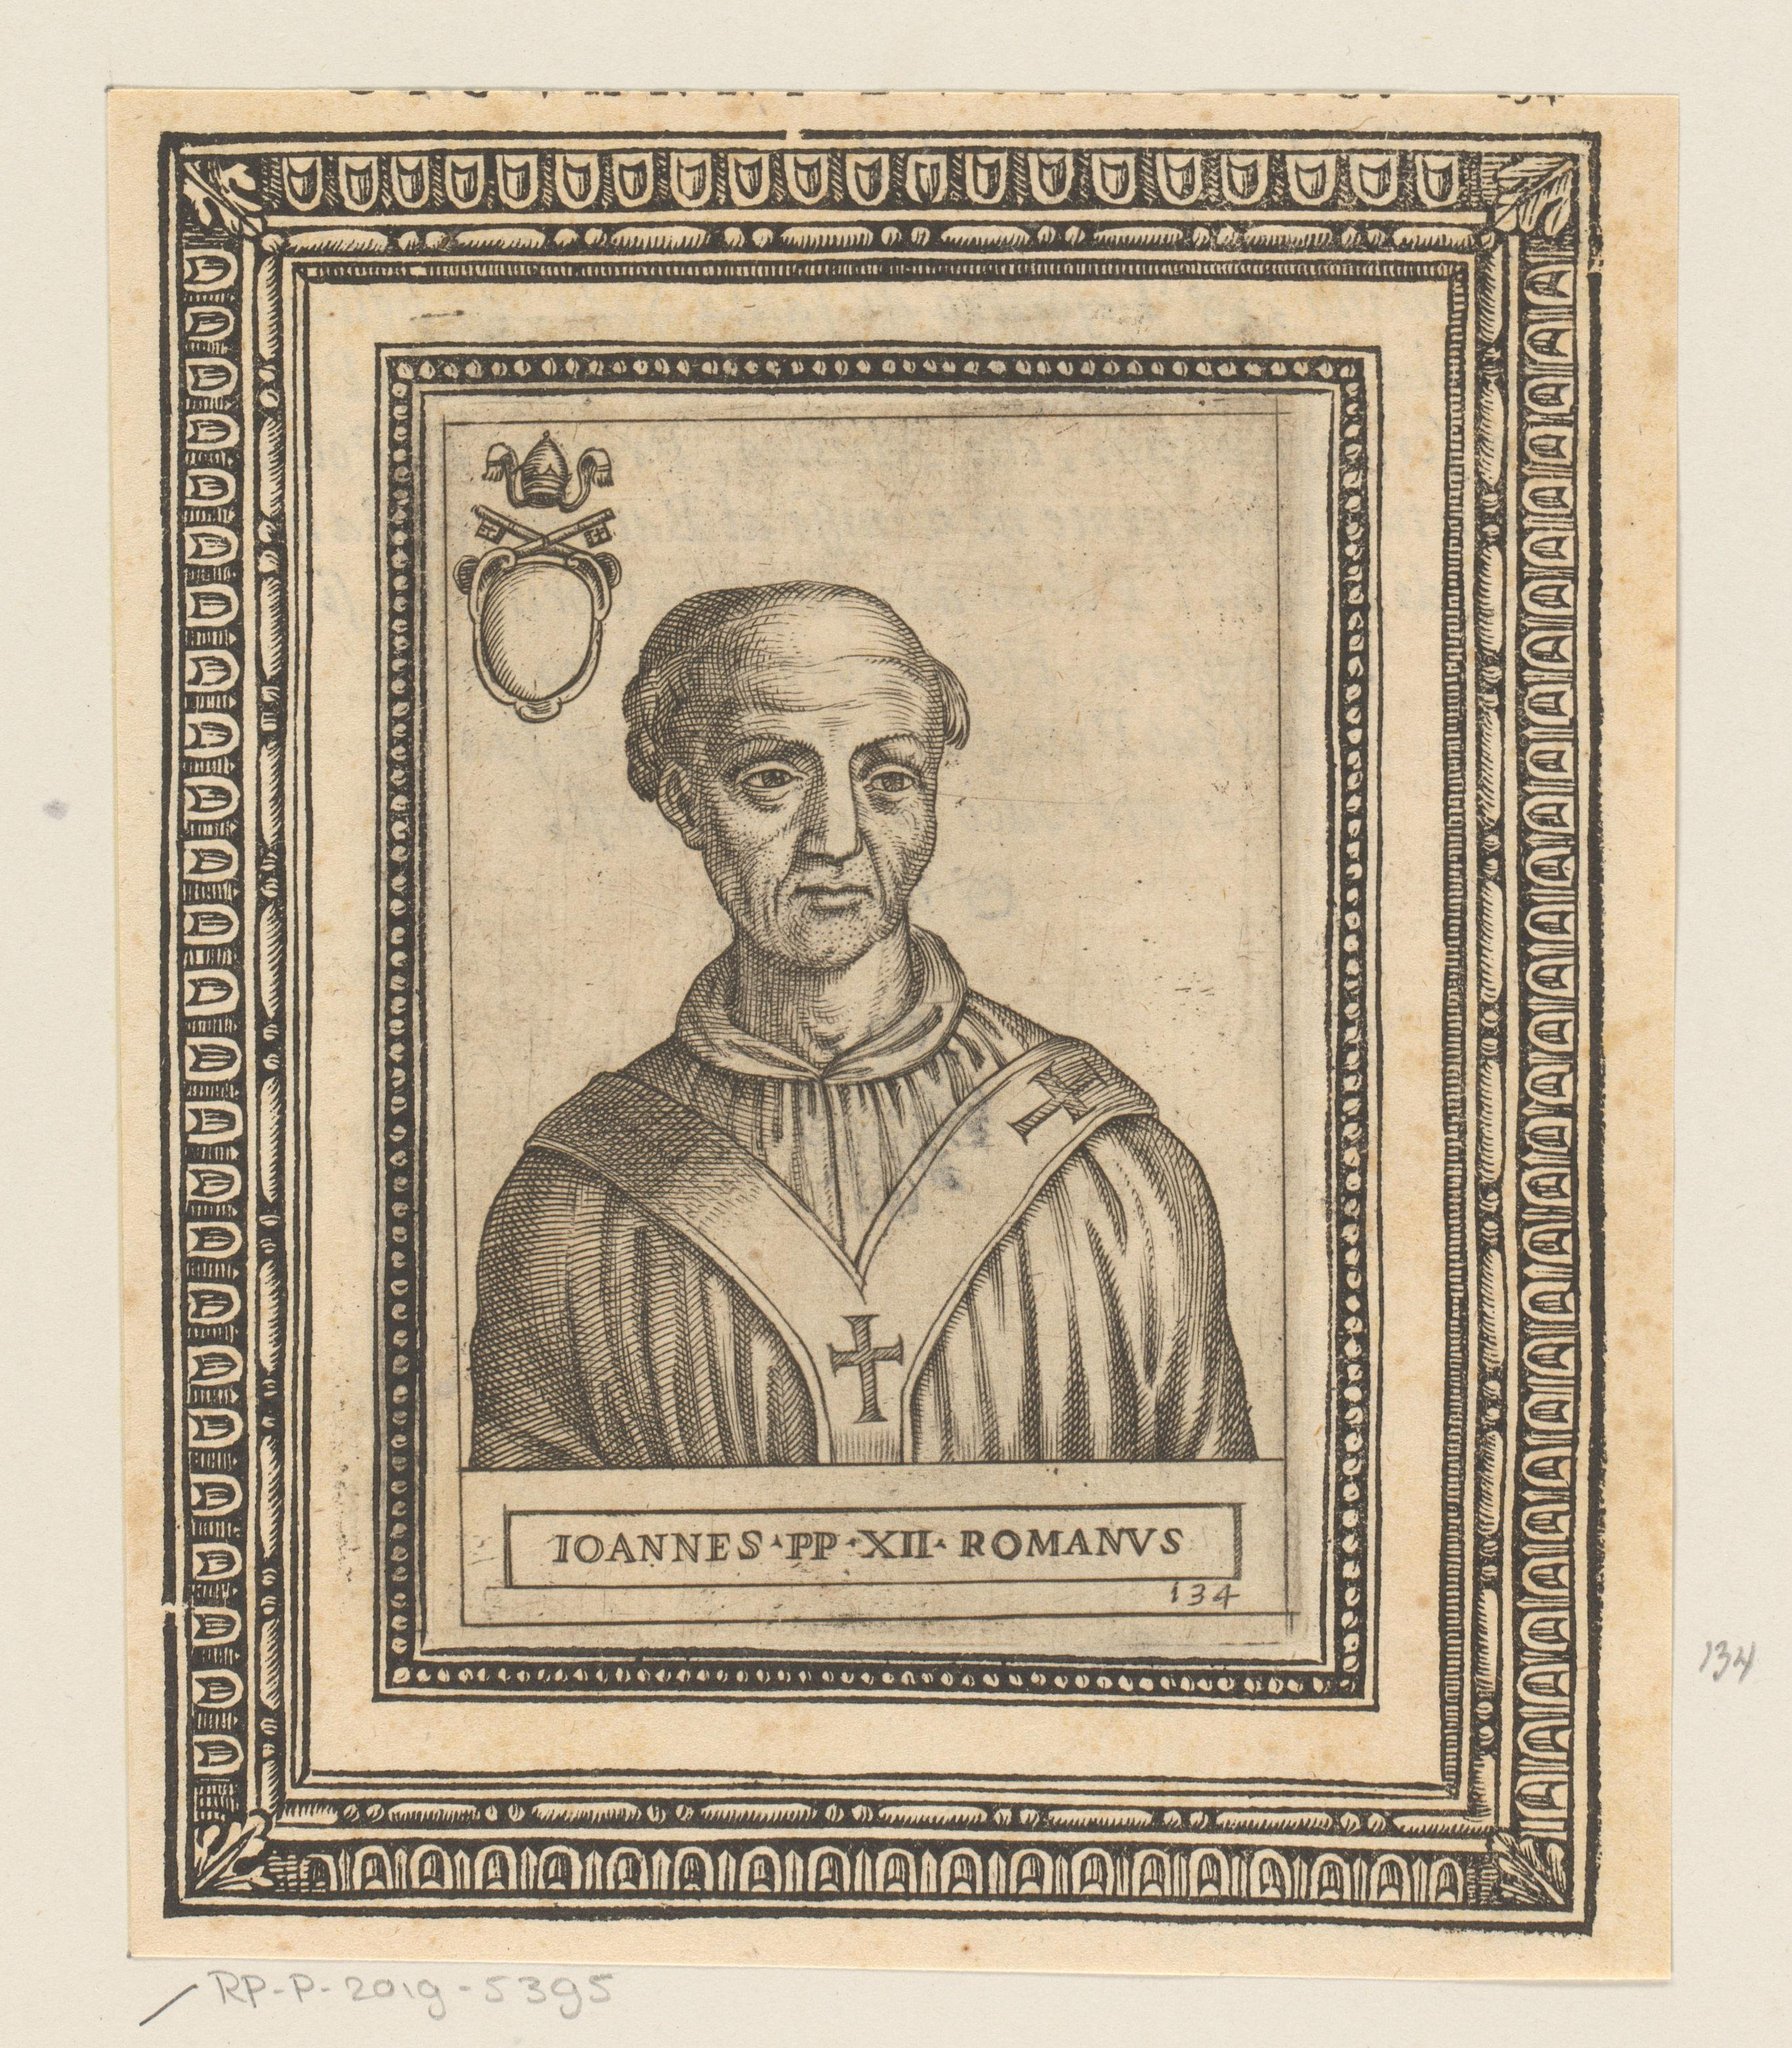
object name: book illustration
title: Linus I PP Volaterra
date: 1587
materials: paper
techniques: engraving, letterpress printing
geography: rome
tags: rome, historical persons, pope, armorial bearing, heraldry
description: Prent uit: Ciccarelli, Antonio. Le vite de Pontefici di Antonio Ciccarelli (...). Rome: Domenico Basa, 1587. Prent voor het eerst verschenen in: Cavalieri, Giovanni Battista de'. Pontificum romanorum effigies (...). Rome: Domenico Basa en Francesco Zanetti, 1580. Prent ook gebruikt in latere publicaties.